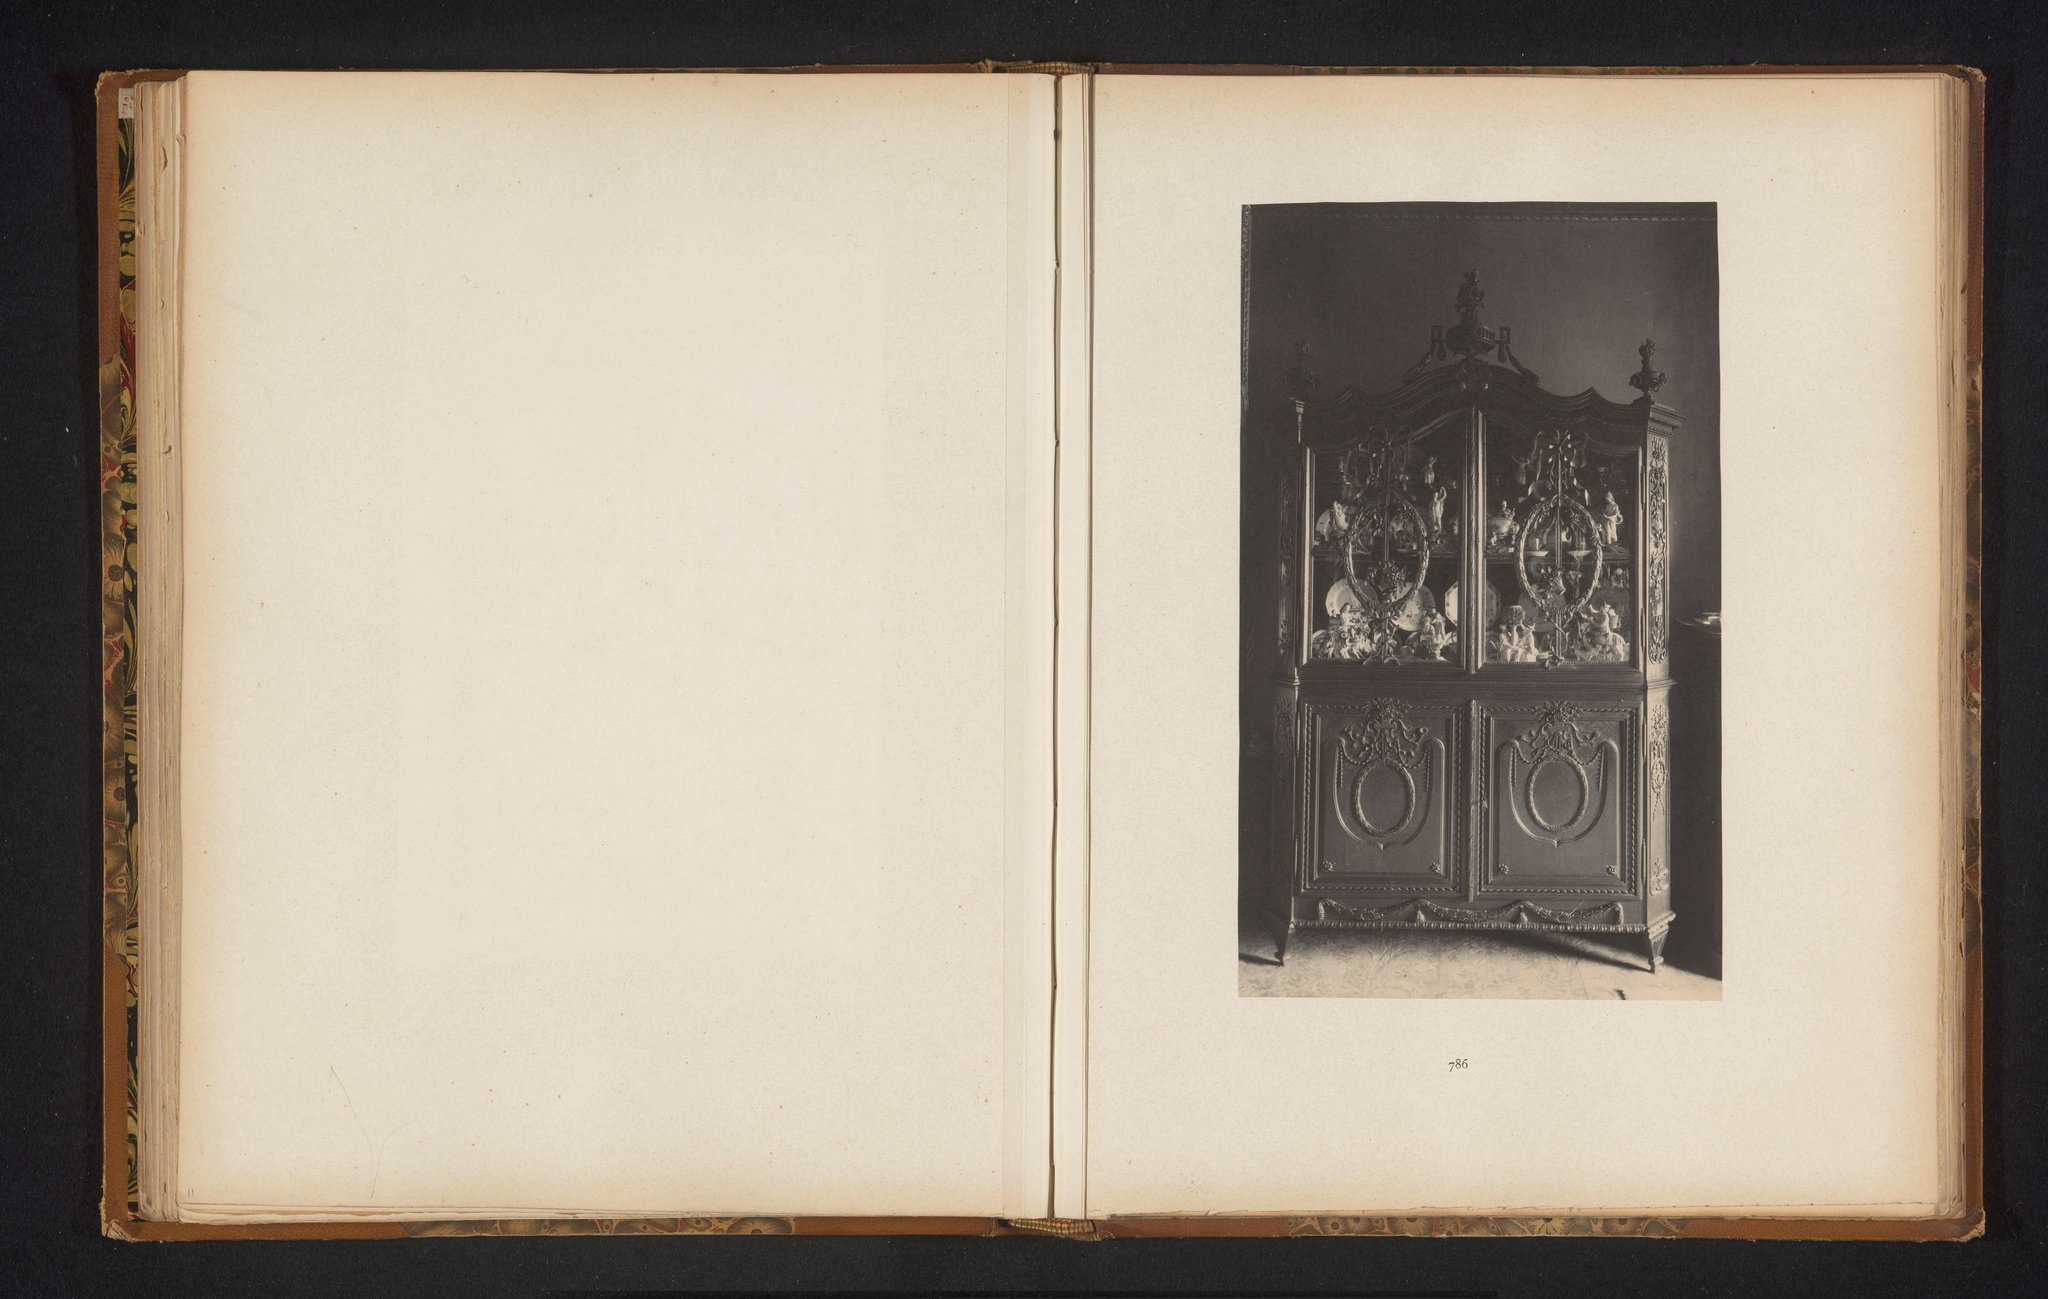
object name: photograph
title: Kast in het huis van Antonin Terme met beelden en borden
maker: Anonymous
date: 1880-1885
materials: photographic support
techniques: platinum process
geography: liège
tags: art collection, art gallery, cabinet of curiosities, 'kunst- und wunderkammer'